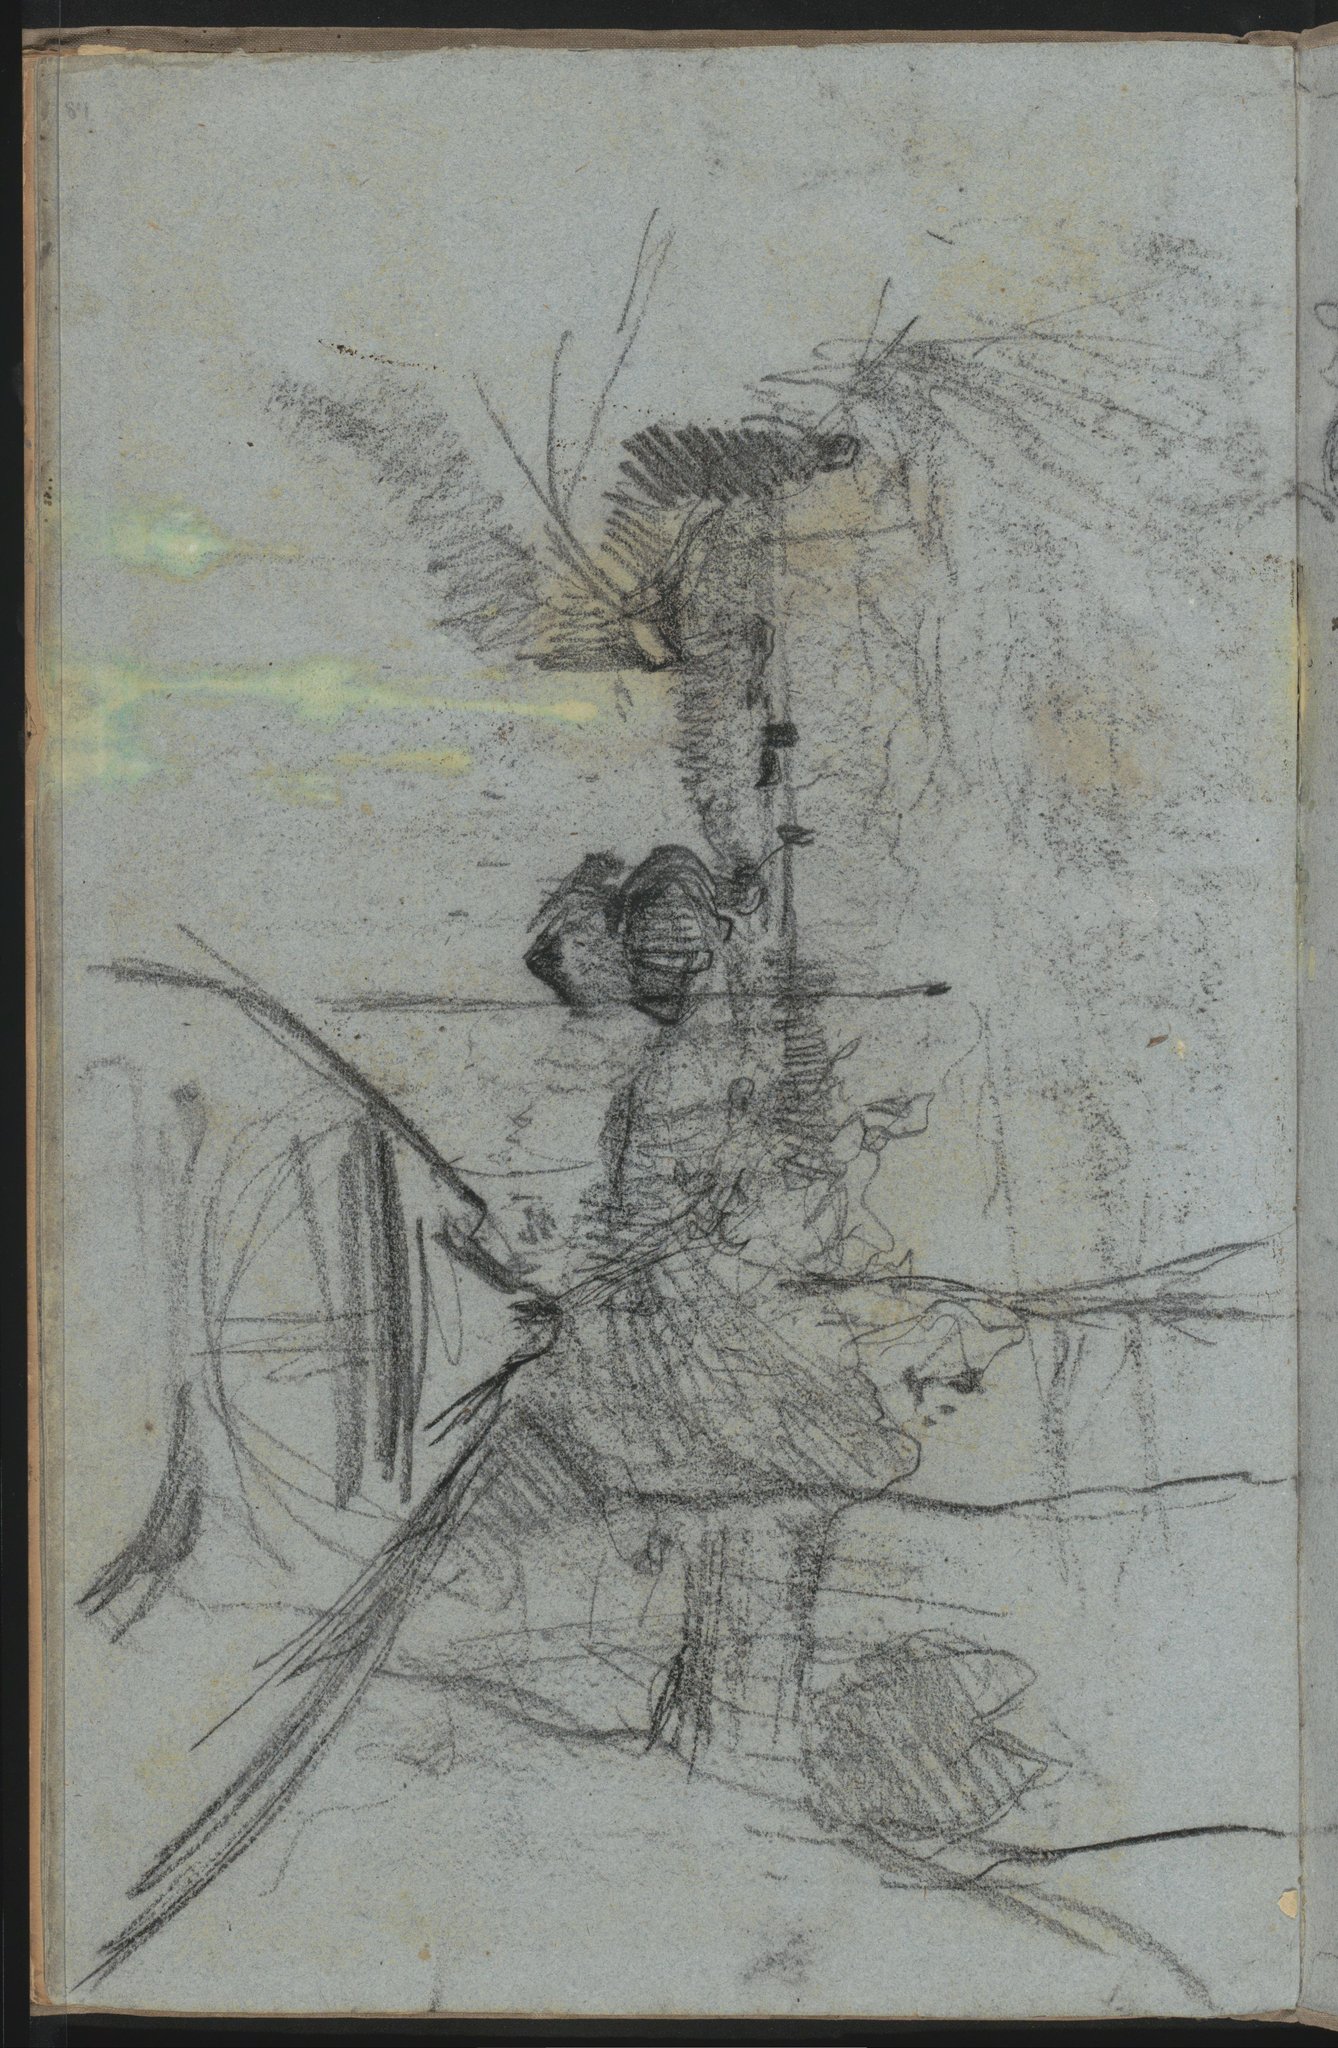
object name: sketchbook leaf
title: Boten in een sloot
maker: willem witsen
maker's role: draughtsman, painter, print maker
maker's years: 1860-1923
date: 1884-1887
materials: chalk, paper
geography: ewijkshoeve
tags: rowing-boat, canoe, etc., small canal, ditch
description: Pagina 84 uit een schetsboek met 42 bladen vervaardigd rond de Ewijkshoeve.